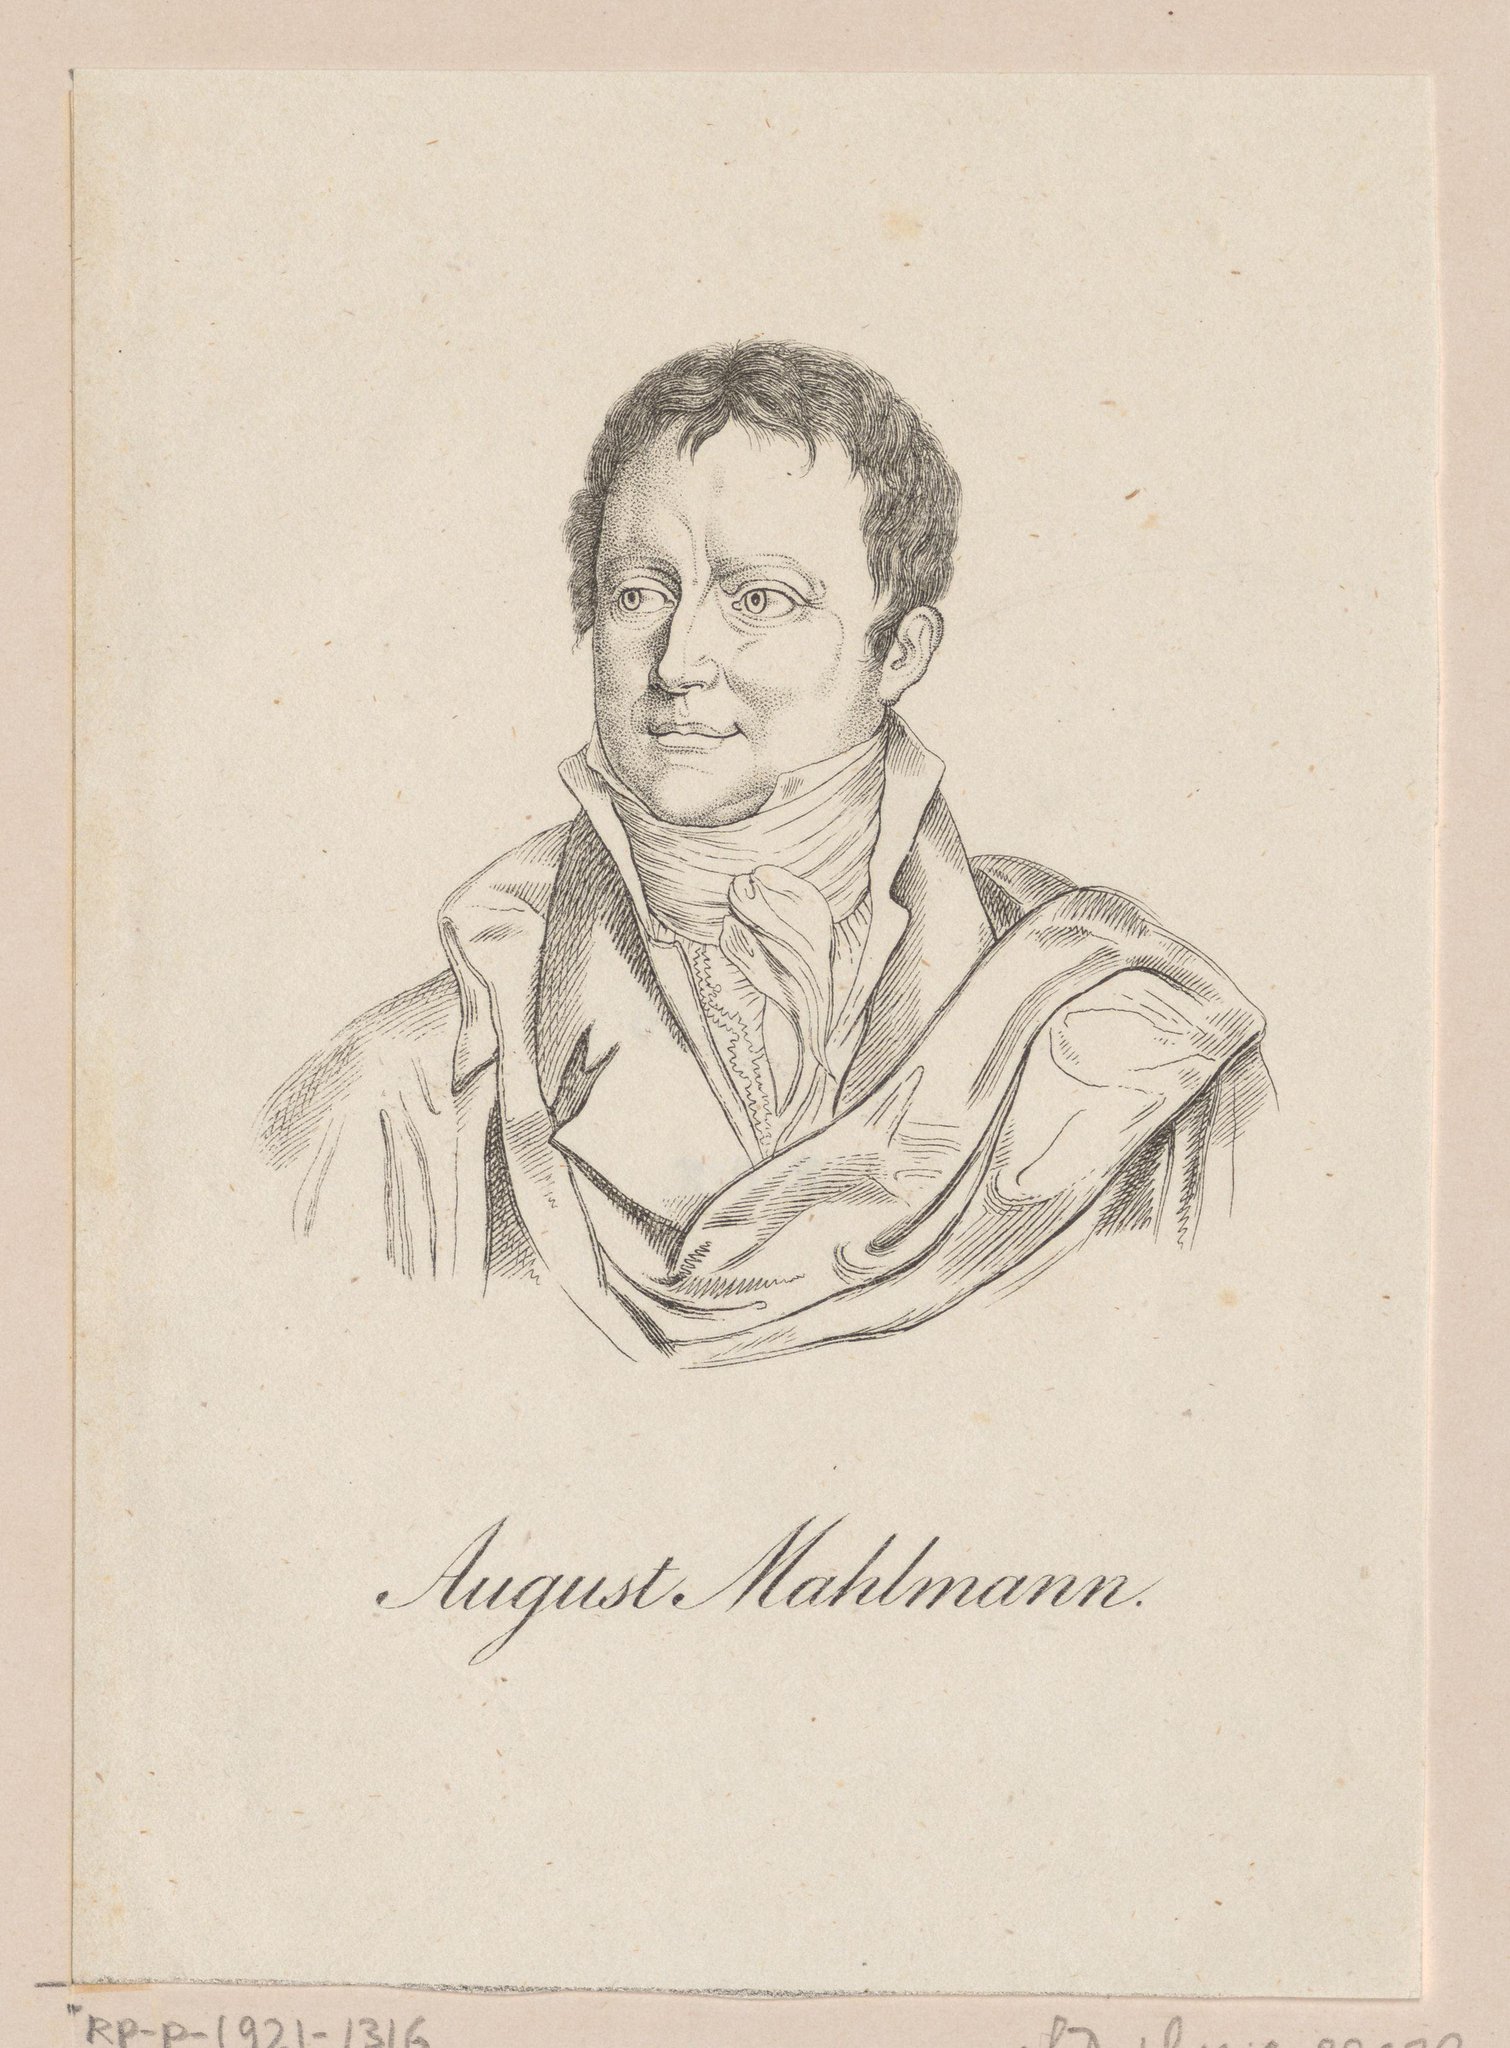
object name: print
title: Portret van Siegfried August Mahlmann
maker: Anonymous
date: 1700-1800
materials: paper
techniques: etching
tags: publisher, historical persons, writer, poet, author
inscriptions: collector's mark: Lugt 2233